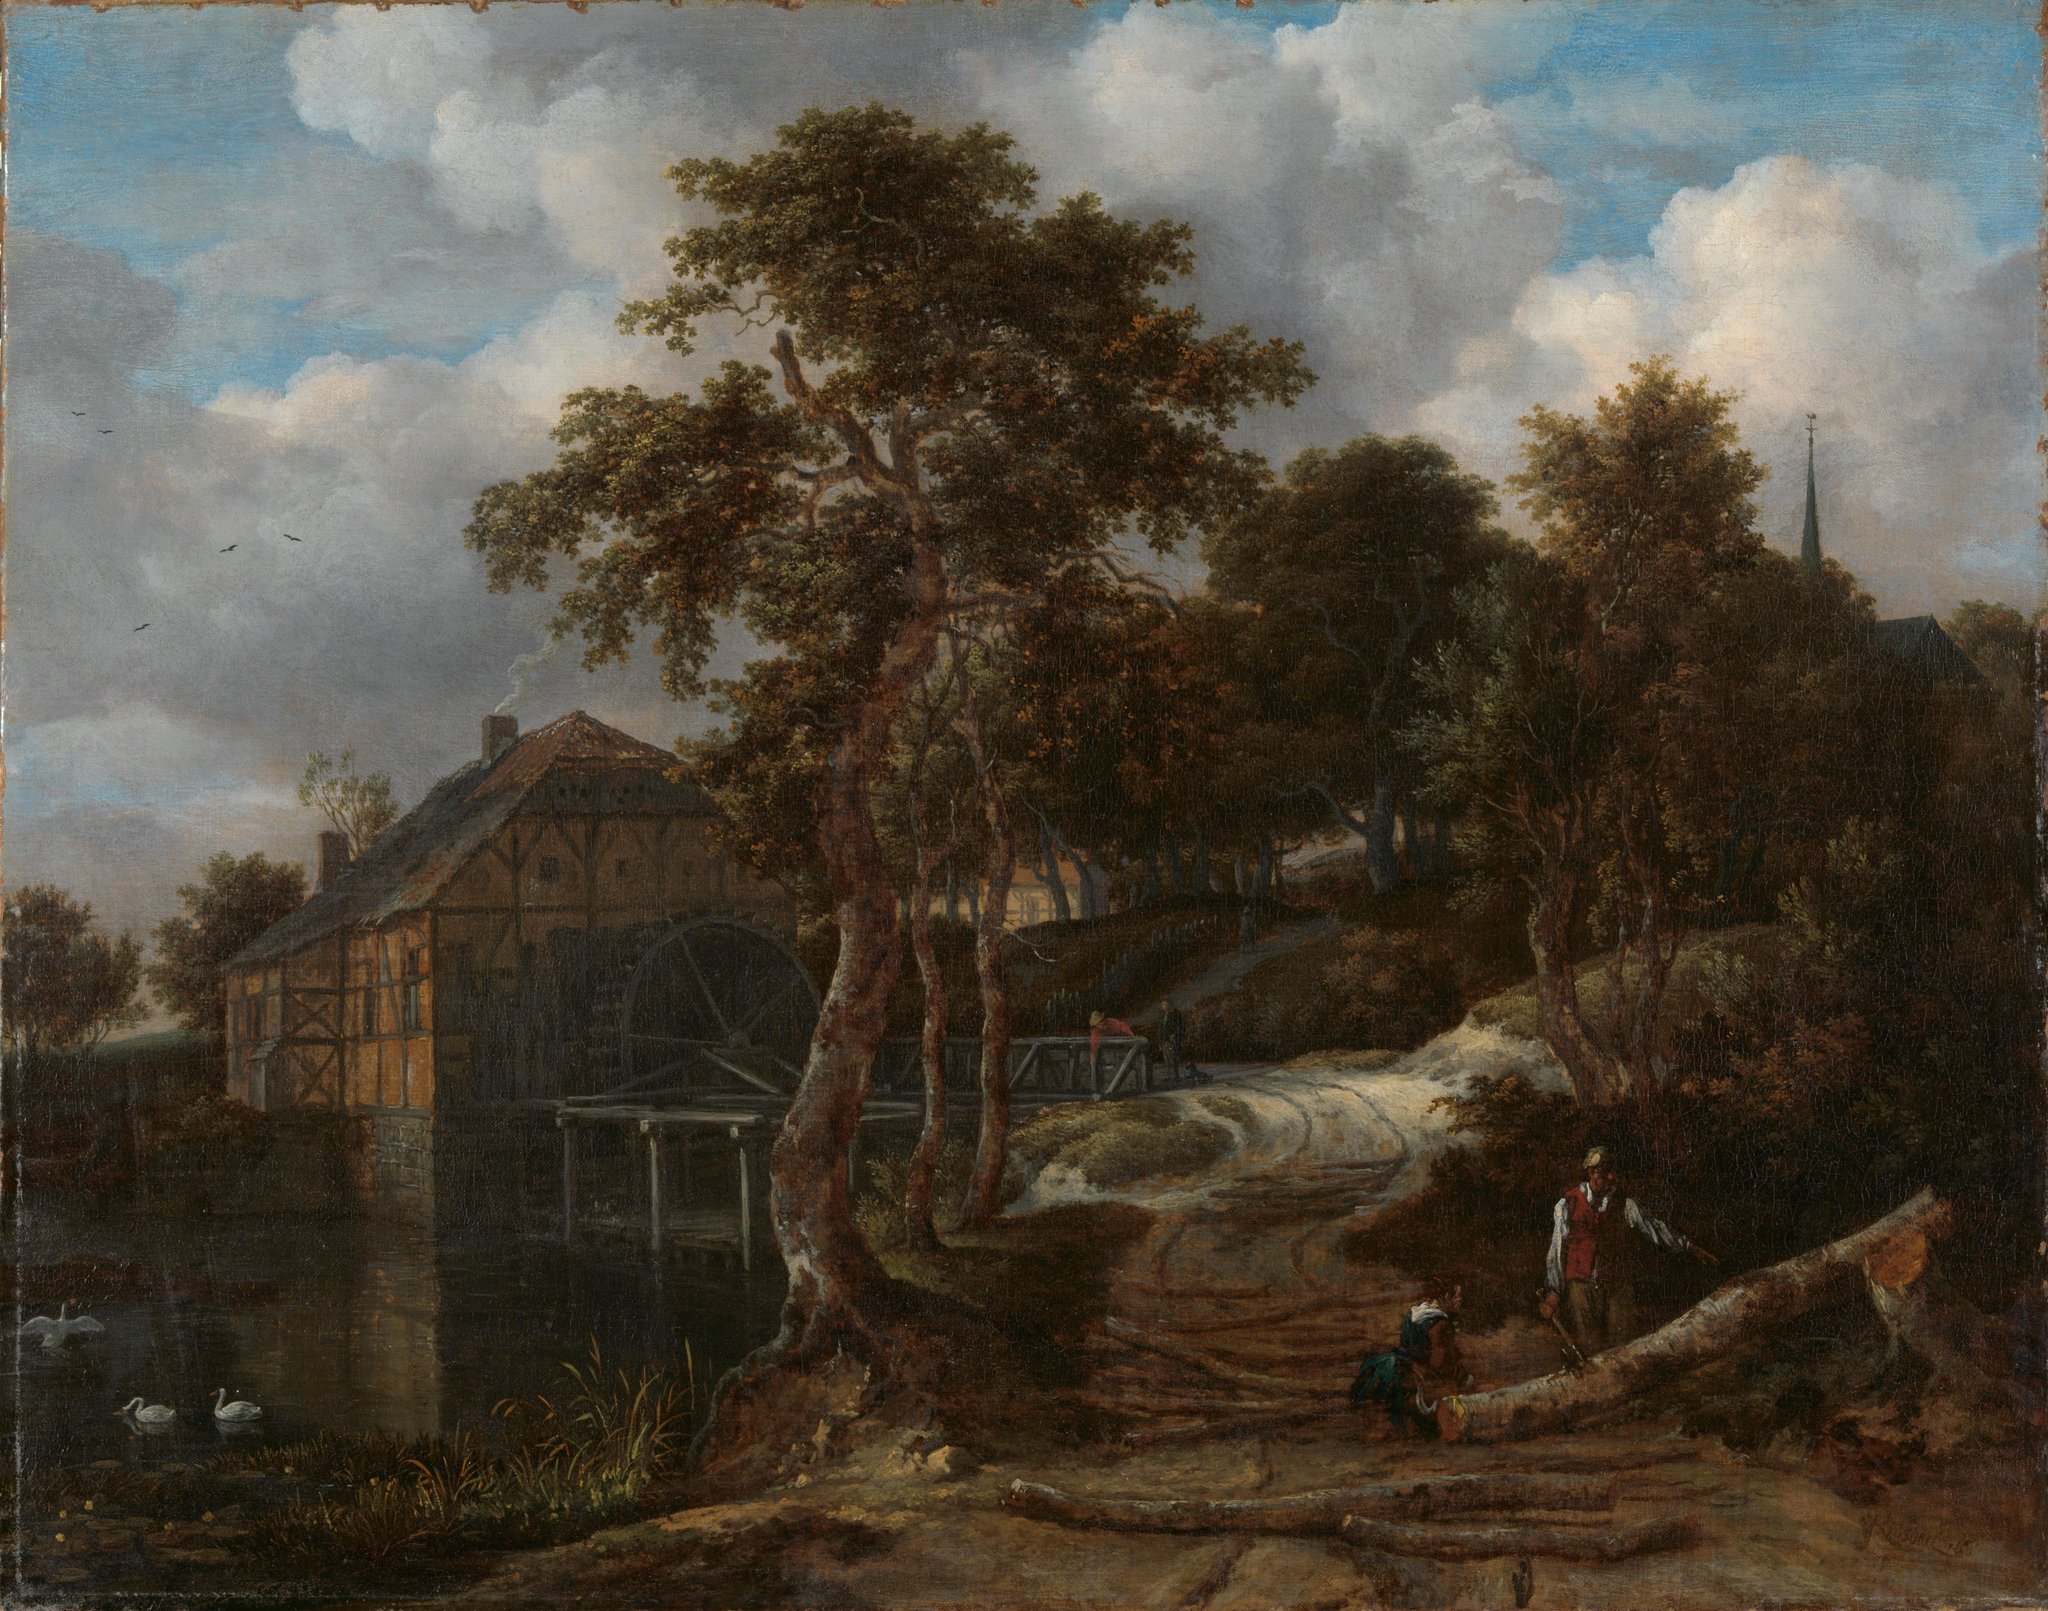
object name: painting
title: Landscape with watermill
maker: jacob isaacksz van ruisdael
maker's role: draughtsman, painter, print maker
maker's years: 1628-1682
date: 1661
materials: canvas, oil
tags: watermill in landscape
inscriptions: signature and date: ‘JVRuisdael 1661’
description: Landschap met watermolen gelegen aan een weg tussen bomen. Links een meertje met zwanen, rechts een houthakker.